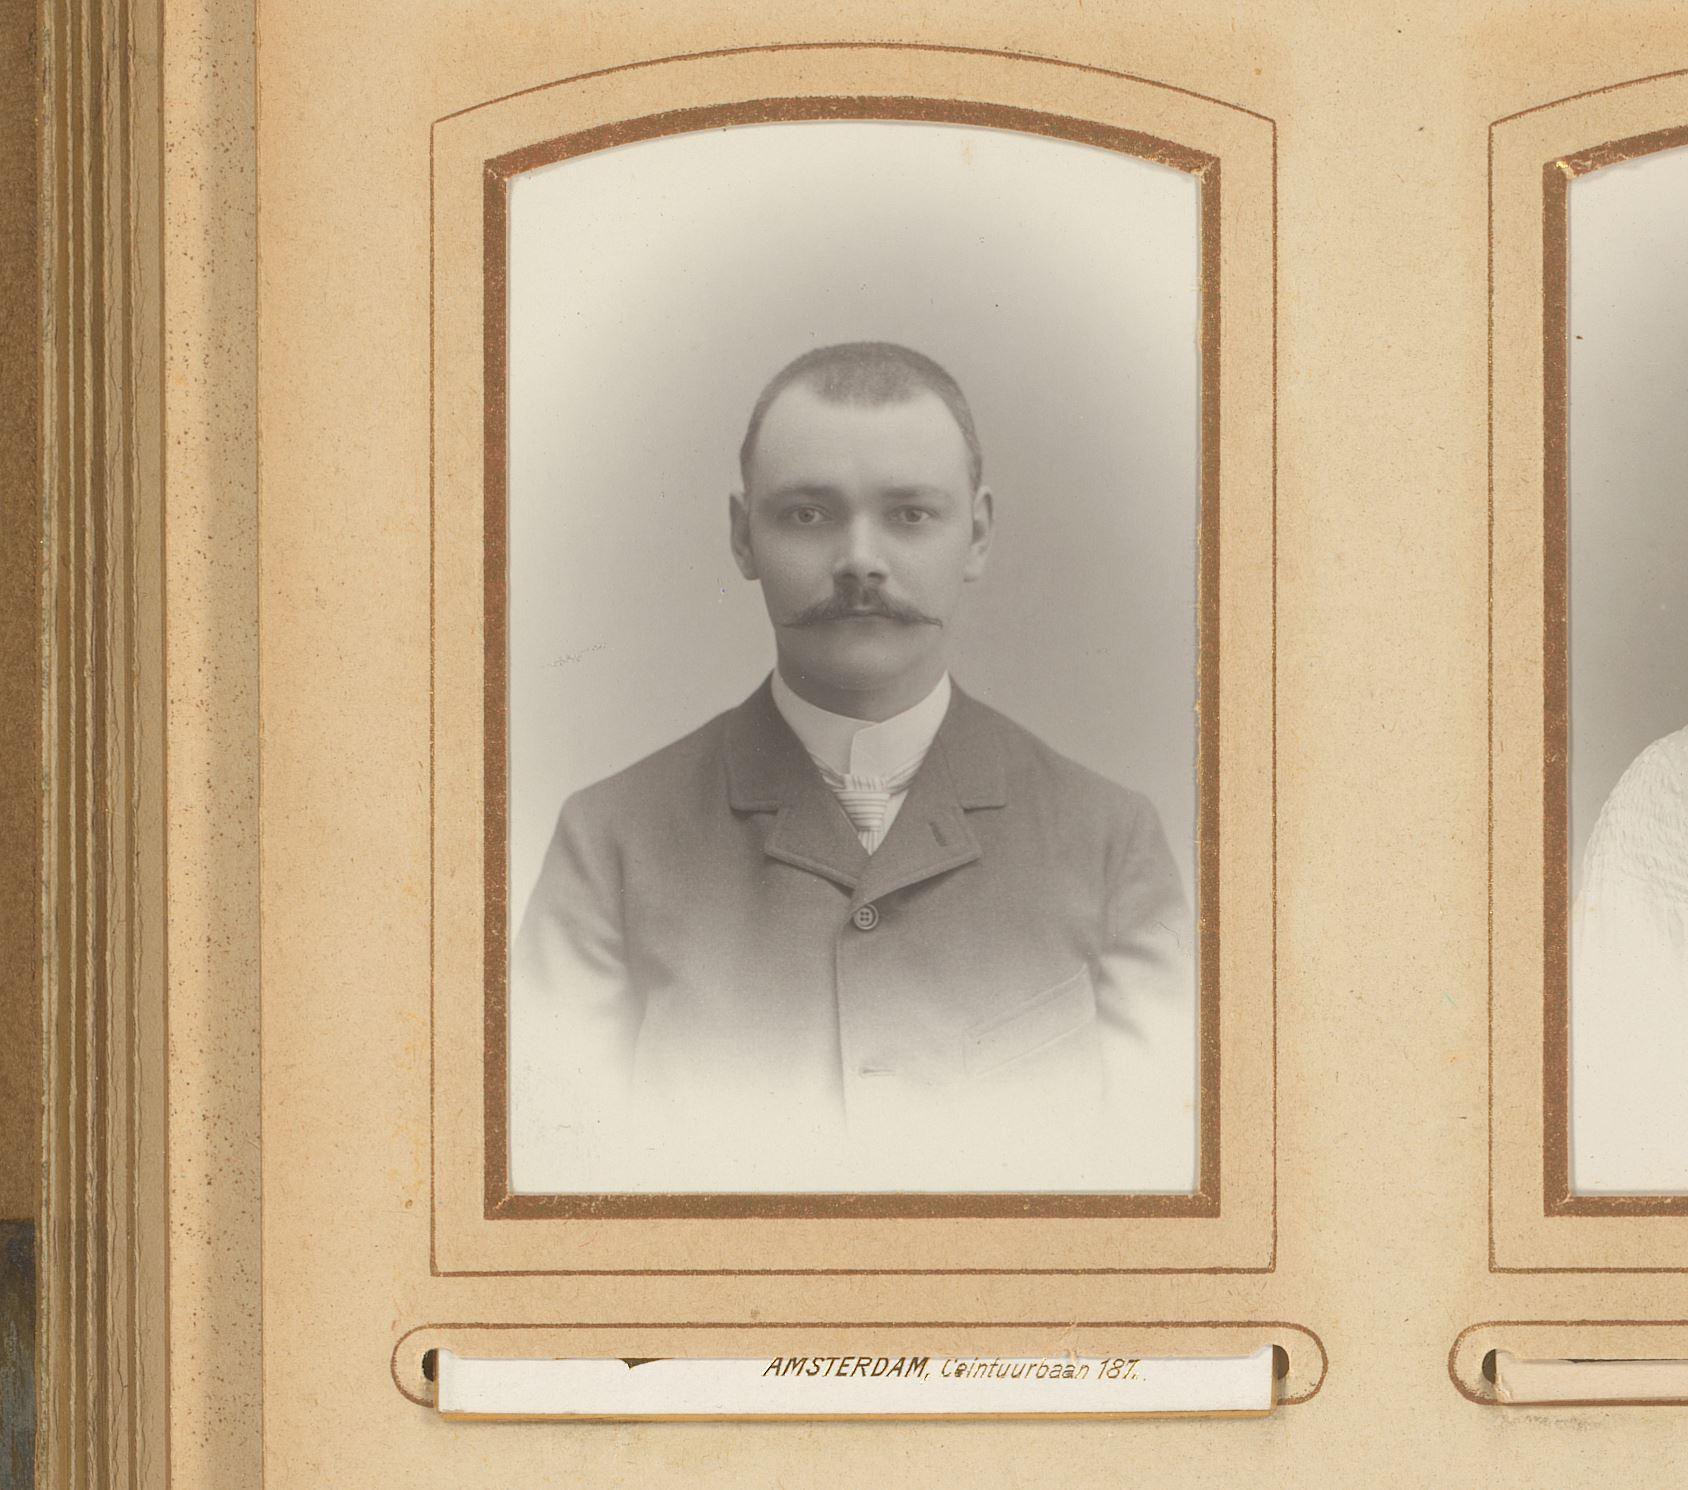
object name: album leaf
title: Portret van een man met snor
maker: franciscus g. lukera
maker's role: fotograaf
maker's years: 1853-1927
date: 1893-1920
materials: cardboard, photographic support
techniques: collodion silver print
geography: amsterdam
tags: moustache, historical persons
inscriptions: inscription: ‘F. Lukera/ Amsterdam, Ceintuurbaan 187’